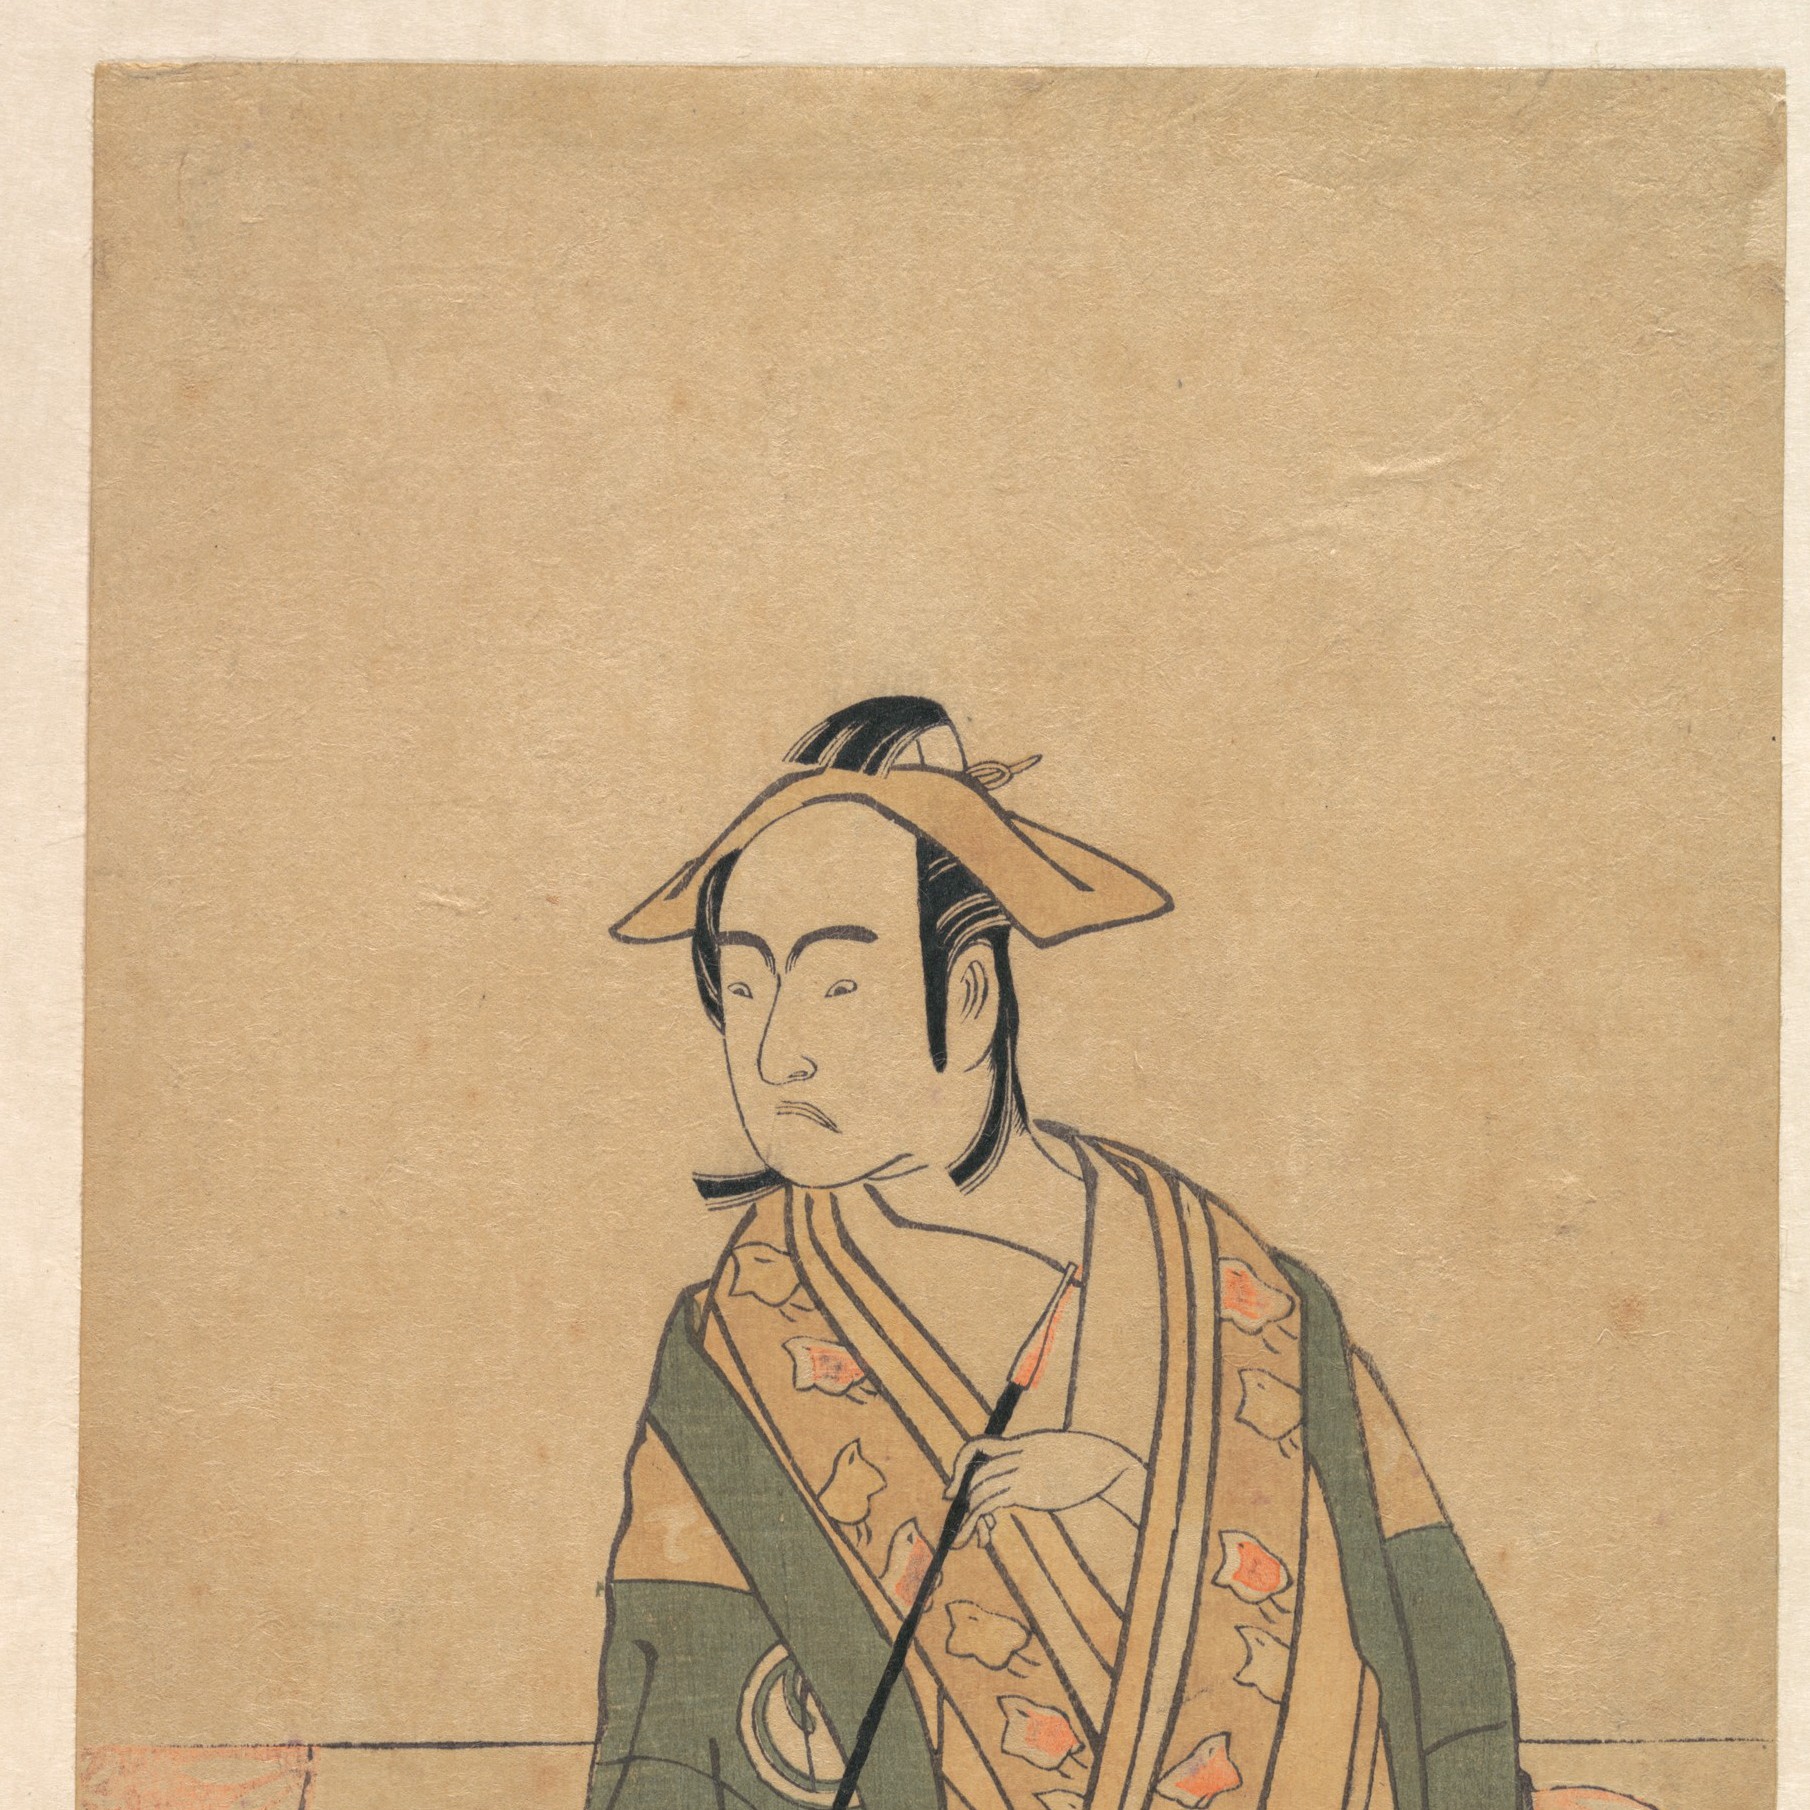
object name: woodblock print nishiki e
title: The Third Sawamura Sojūrō in the Role of Soga no Jūrō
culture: japanese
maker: katsukawa shunshō 勝川春章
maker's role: artist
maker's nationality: japanese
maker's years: 1726-1792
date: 1779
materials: ink, paper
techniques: nishiki e, woodblock print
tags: men,actors